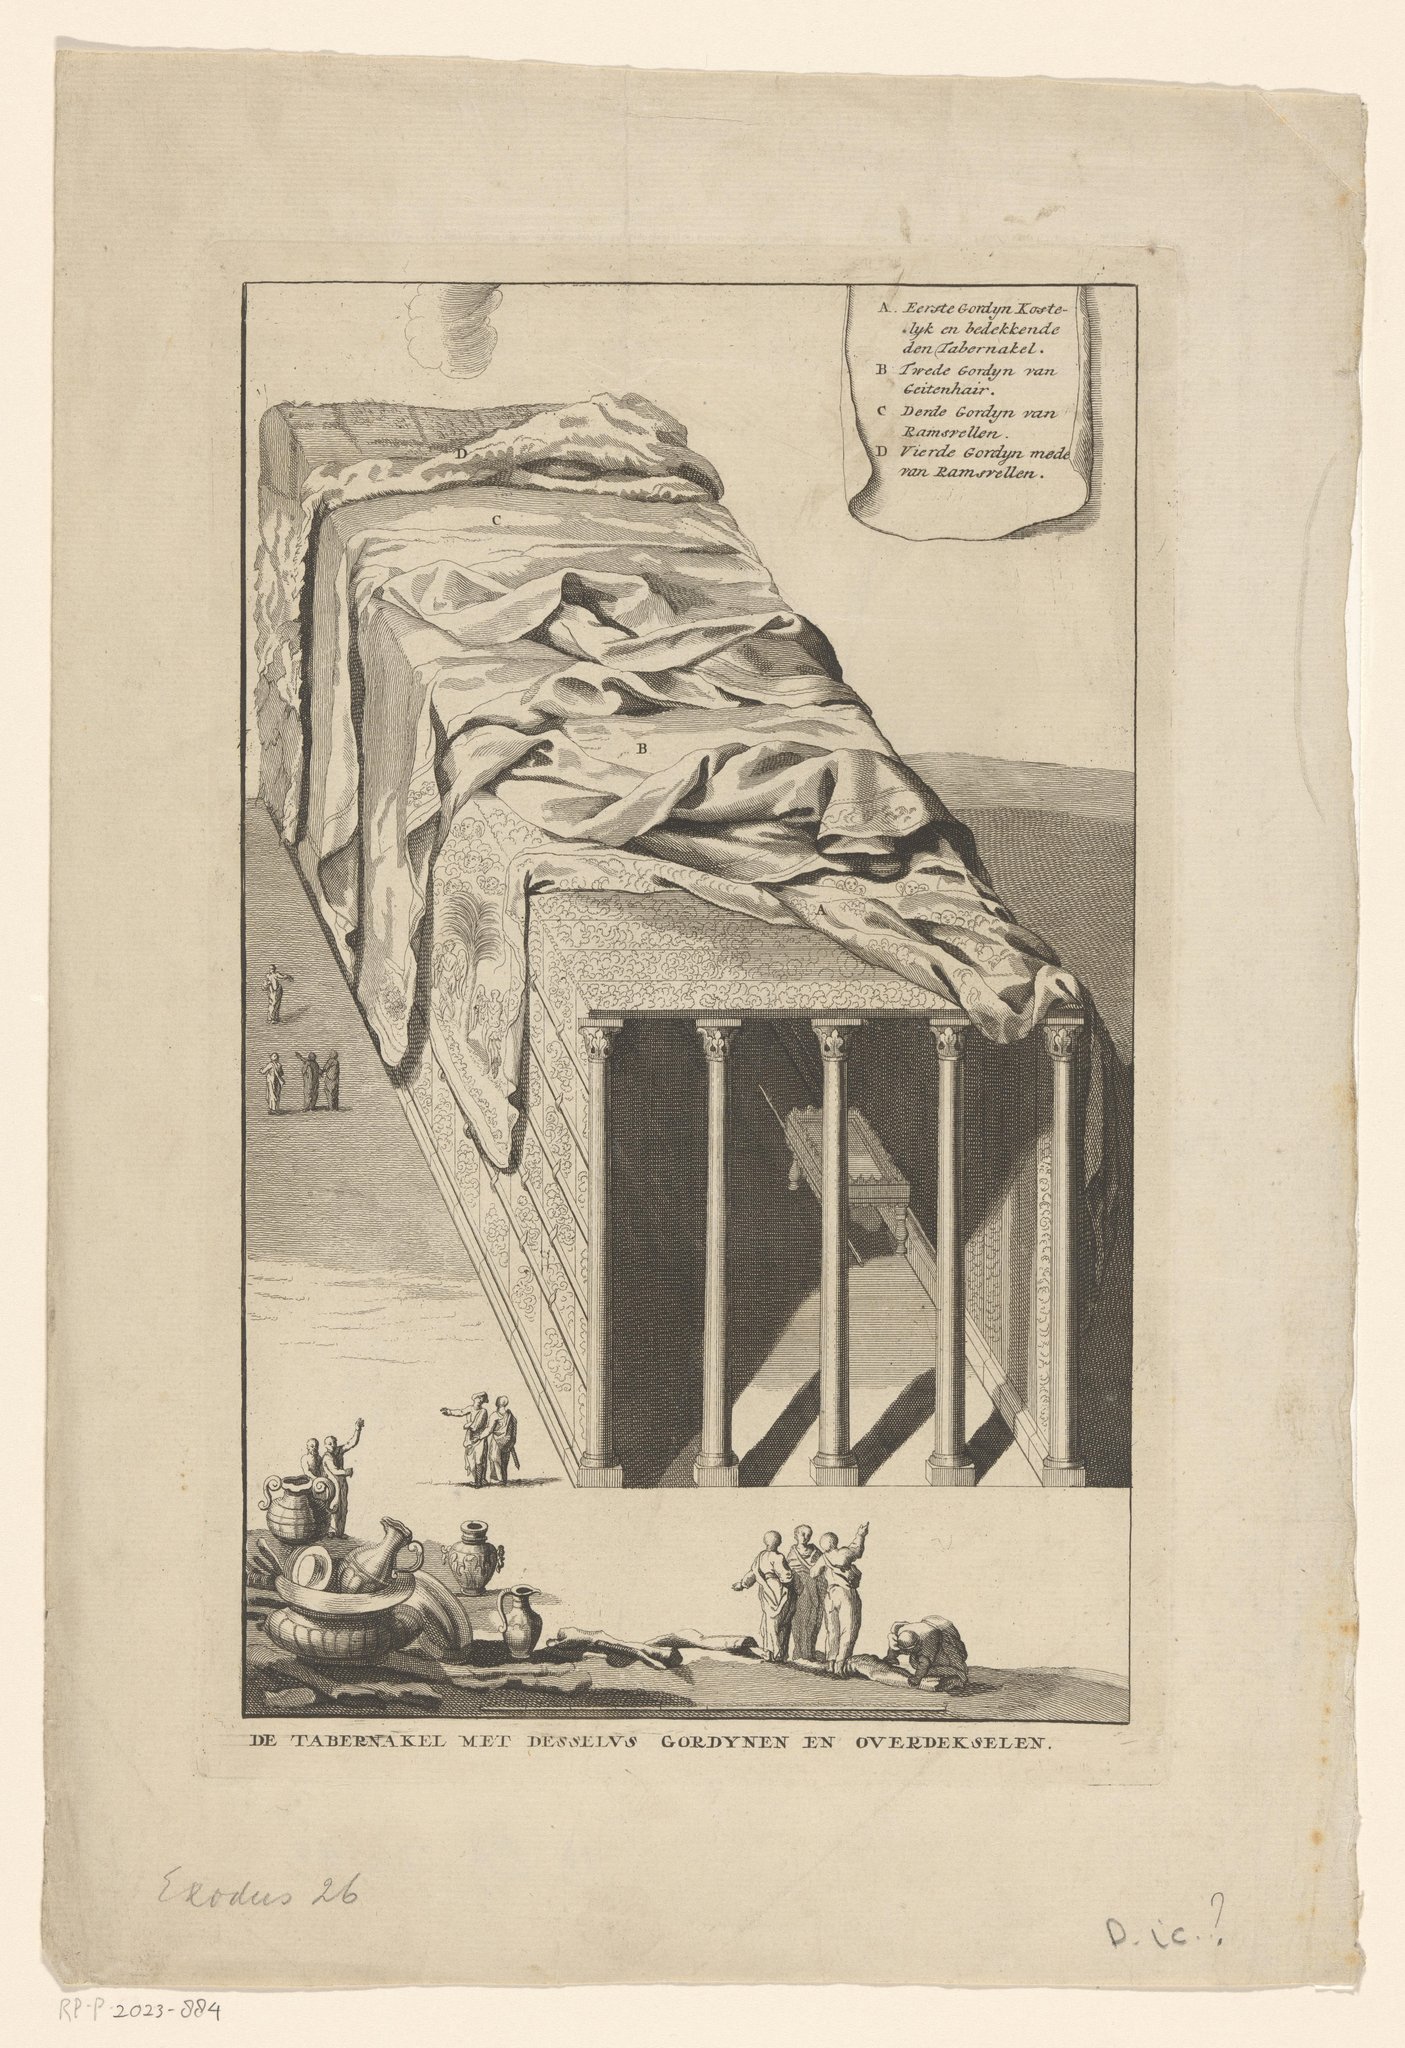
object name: print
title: De Tabernakel met desselvs gordynen en overdekselen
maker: Anonymous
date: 1727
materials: paper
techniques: engraving, etching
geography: netherlands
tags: preparation and setting up of the tabernacle and its accessories ~ exodus (exodus 35-40), tabernacle ~ altar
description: Gebruikt als illustratie in: Het algemeen groot historisch, oordeelkundig, chronologisch, geografisch, en letterlyk naam- en woord-boek, van den gantschen H. Bijbel. Dienende tot de gedenk-stukken der Jooden en andere oudheden, ter opheldering der H. Schrift . Nu in't Nederduitsch overgezet, merkelyk vermeerdert, en met aanmerkingen verrykt, door Mattheus Gargon.' and it's additons: 'Byvogzel tot het algemeen groot . Naam- en woord-boek . En nu in zuiver Nederduitsch overgezet, merkelyk vermeerdert, en metv aanmerkingen verrykt, door Jakob van Ostade en Arn. Henr. Westerhovius.', by Augustines Calmet, published in Leiden, Amsterdam, by Samuel Luchtmans, R. & J. Wetstein en Smith 1725-1731. Dl. II (1727), p. 364/365. De prenten in dit werk zijn vervaardigd door: A. de Putter, F. van Bleyswyk, M. Pool, Ph. van Gunst, e.a.